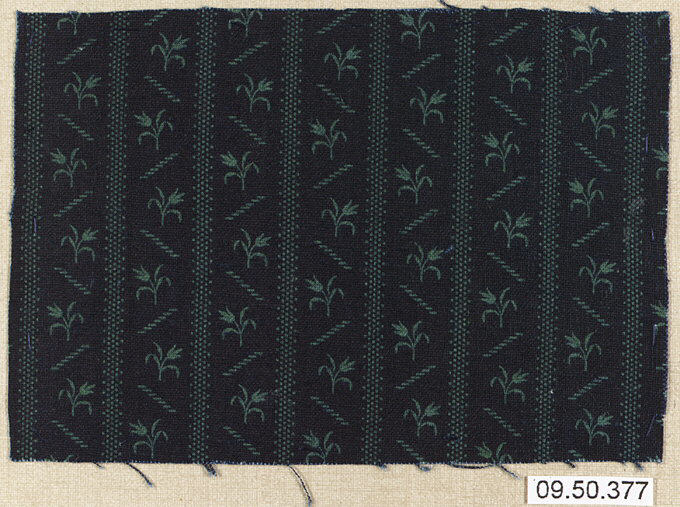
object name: piece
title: Piece (one of 116)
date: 1801-1900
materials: cotton